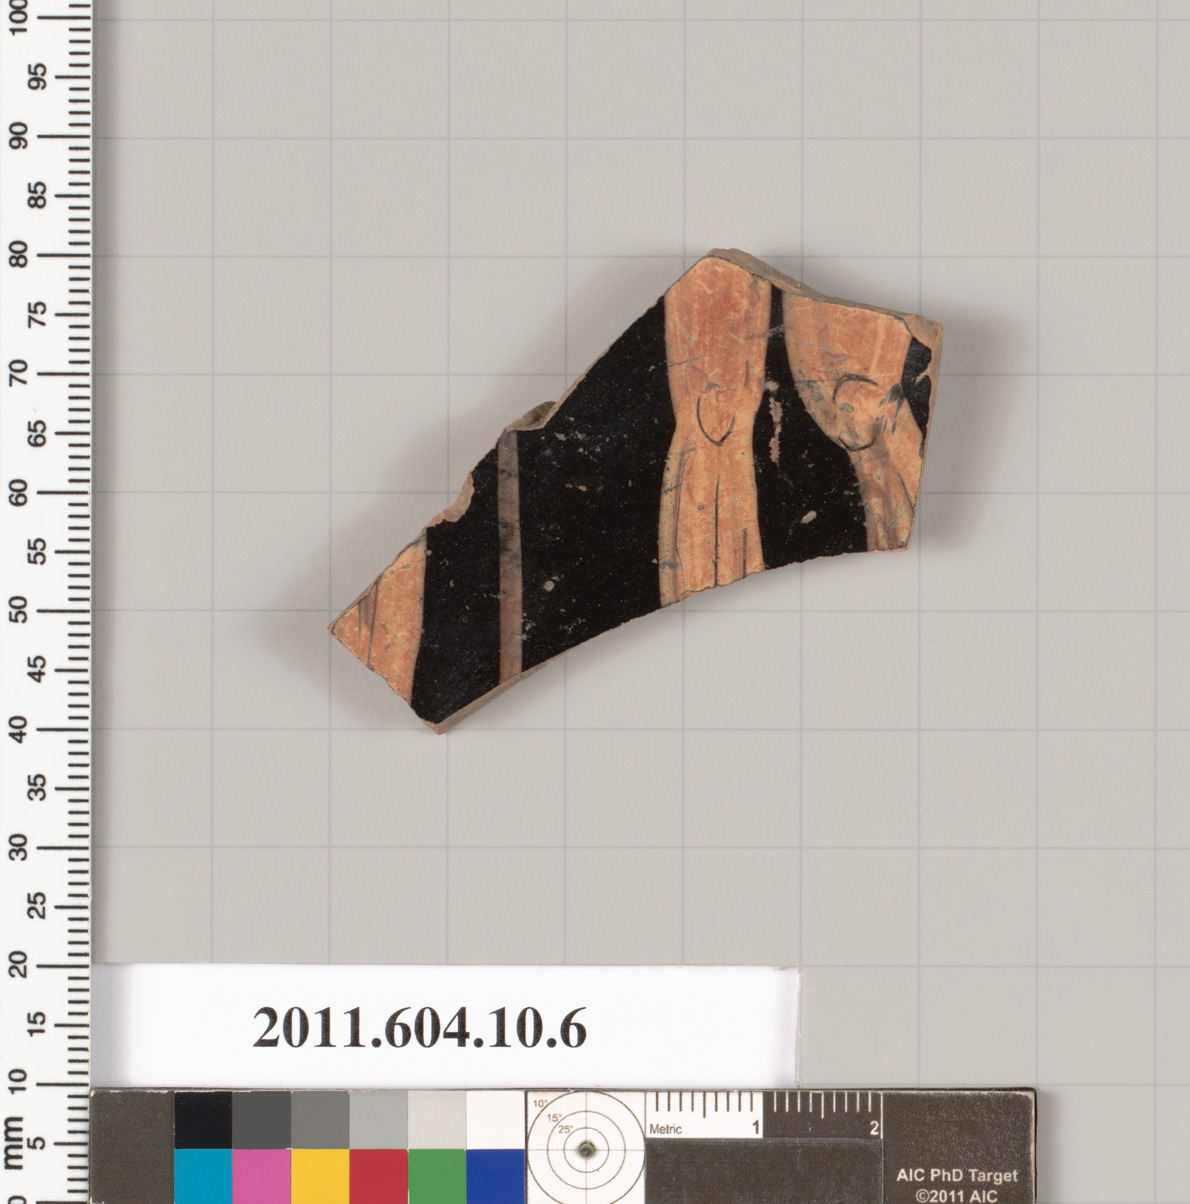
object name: kylix fragment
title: Terracotta fragment of a kylix (drinking cup)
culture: etruscan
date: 434-368 BCE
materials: terracotta